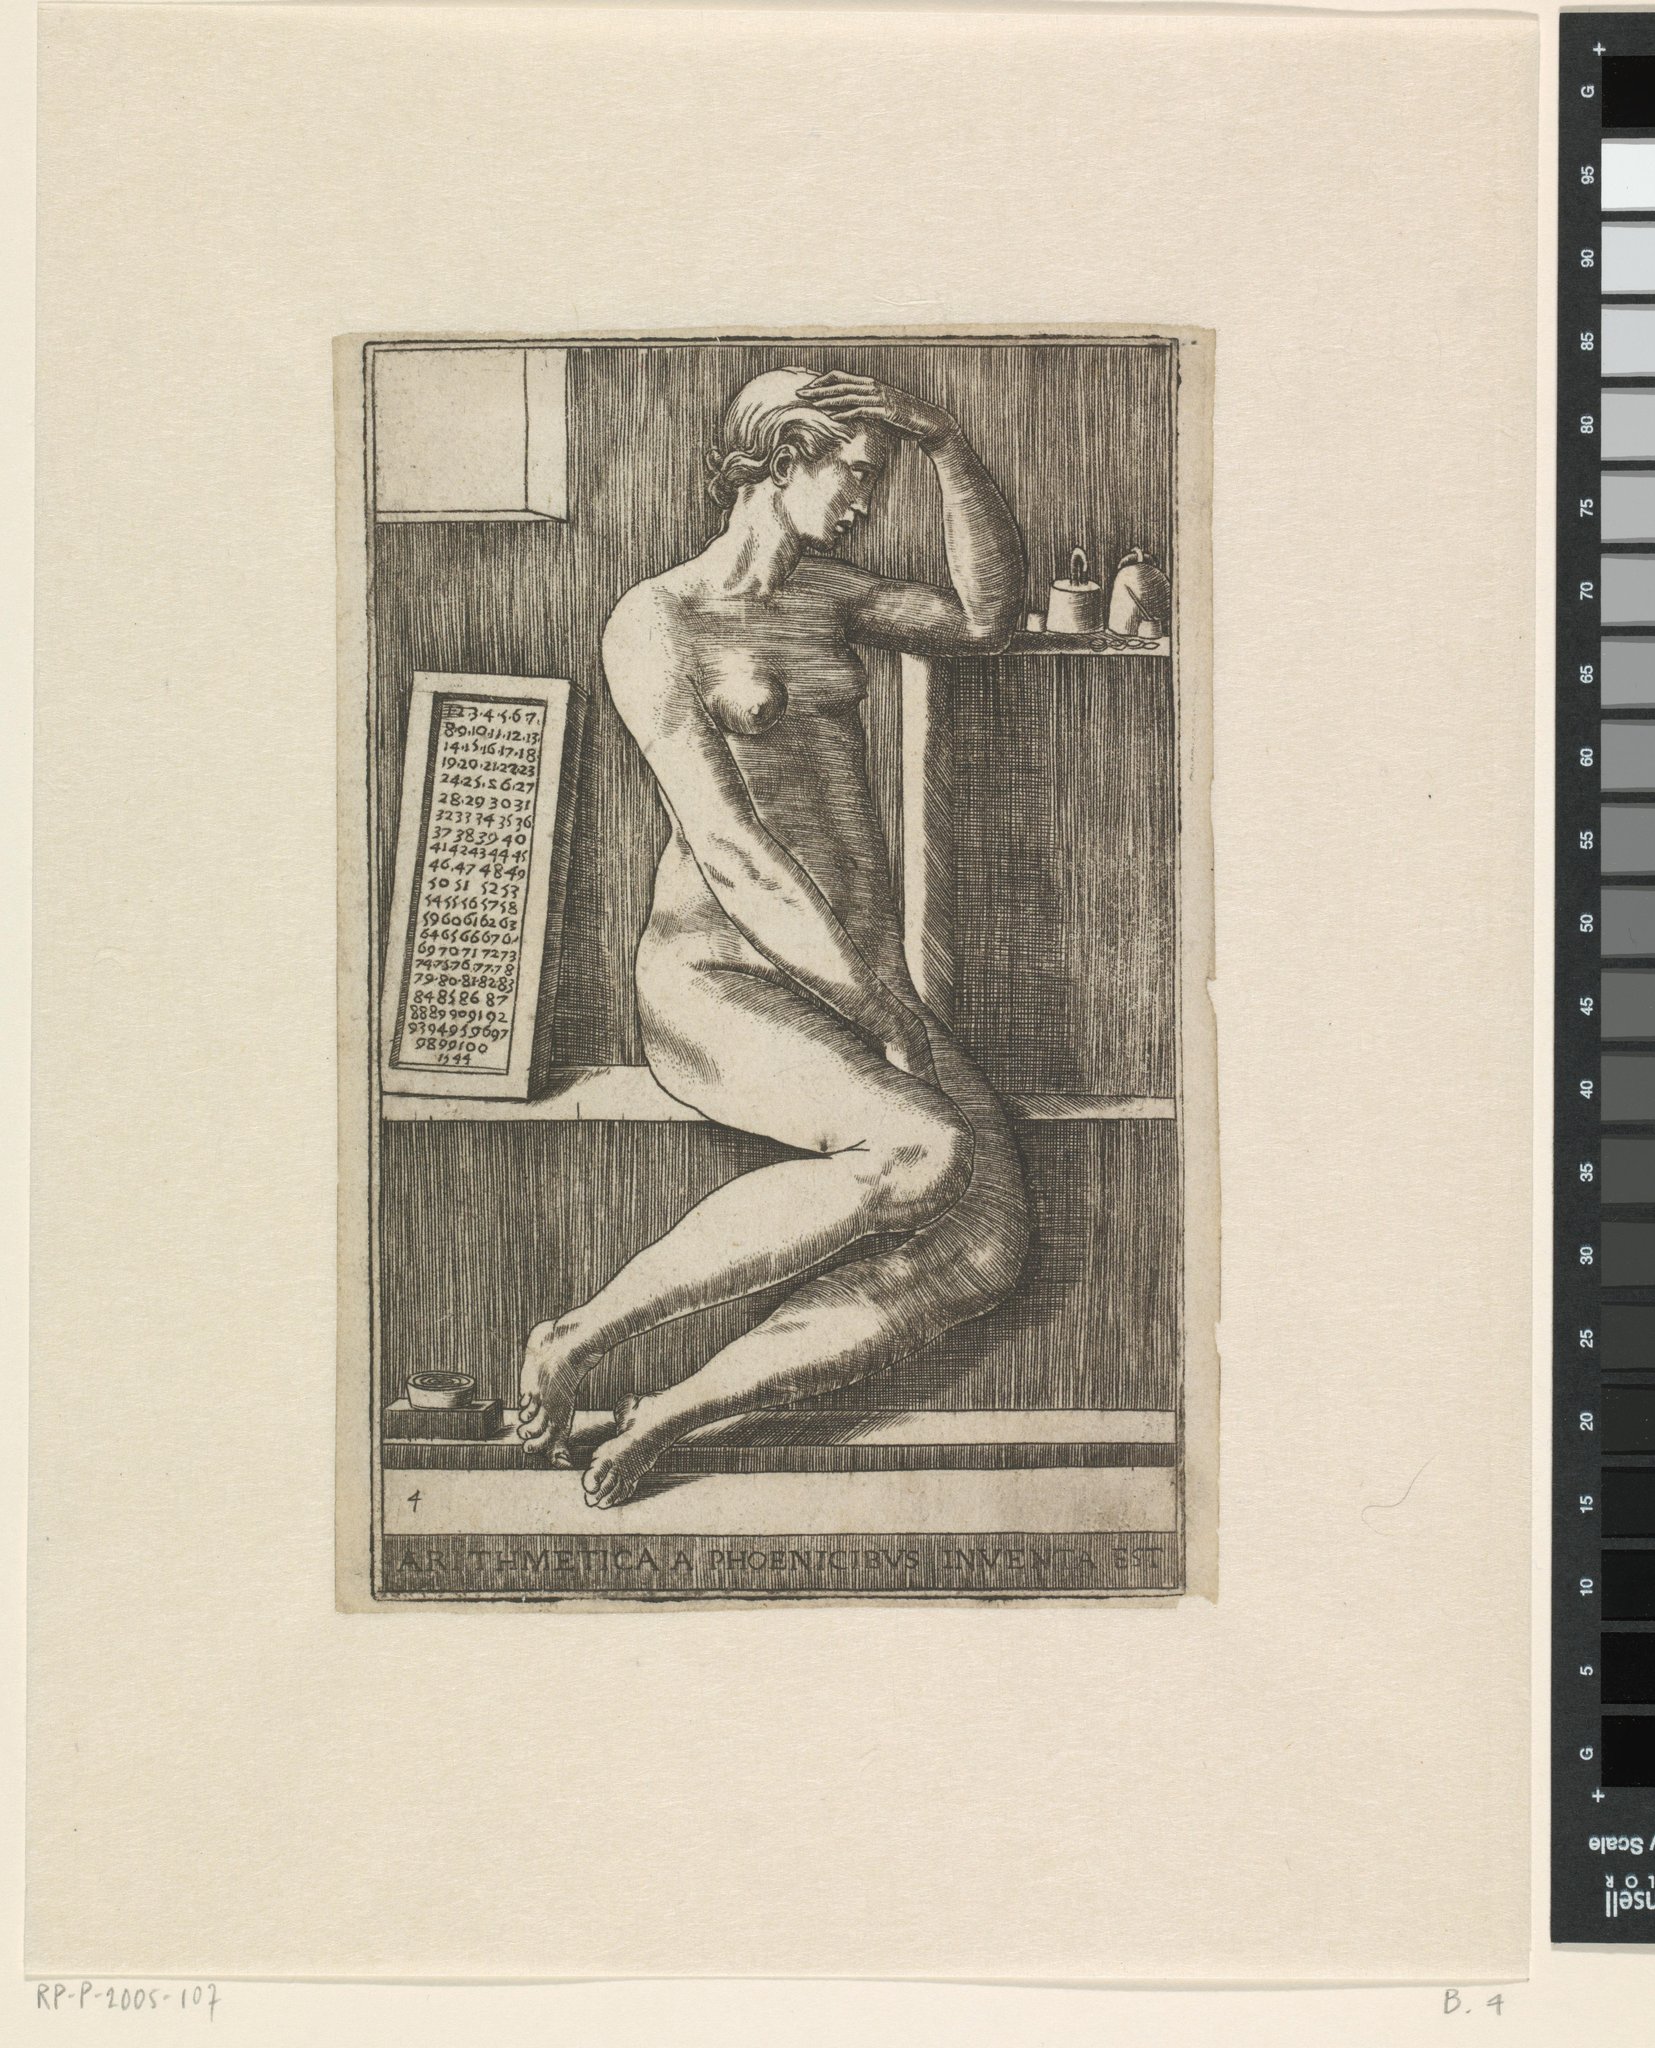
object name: print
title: Arithmetica a phoenicibus inventa est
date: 1544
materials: paper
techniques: engraving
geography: italy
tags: the liberal arts, 'artes liberales', 'arithmetica' (~ quadrivium); 'aritmetica' (ripa), counting-board, counter, counter-table, weight used on scales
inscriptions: collector's mark: Lugt 2760, collector's mark: Lugt 2228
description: Personificatie van aritmetica: naakte vrouw, zittend, naar rechts, in peinzende houding. Voor haar staan gewichten en liggen geldstukken. Achter haar een rekenbord met cijfers.